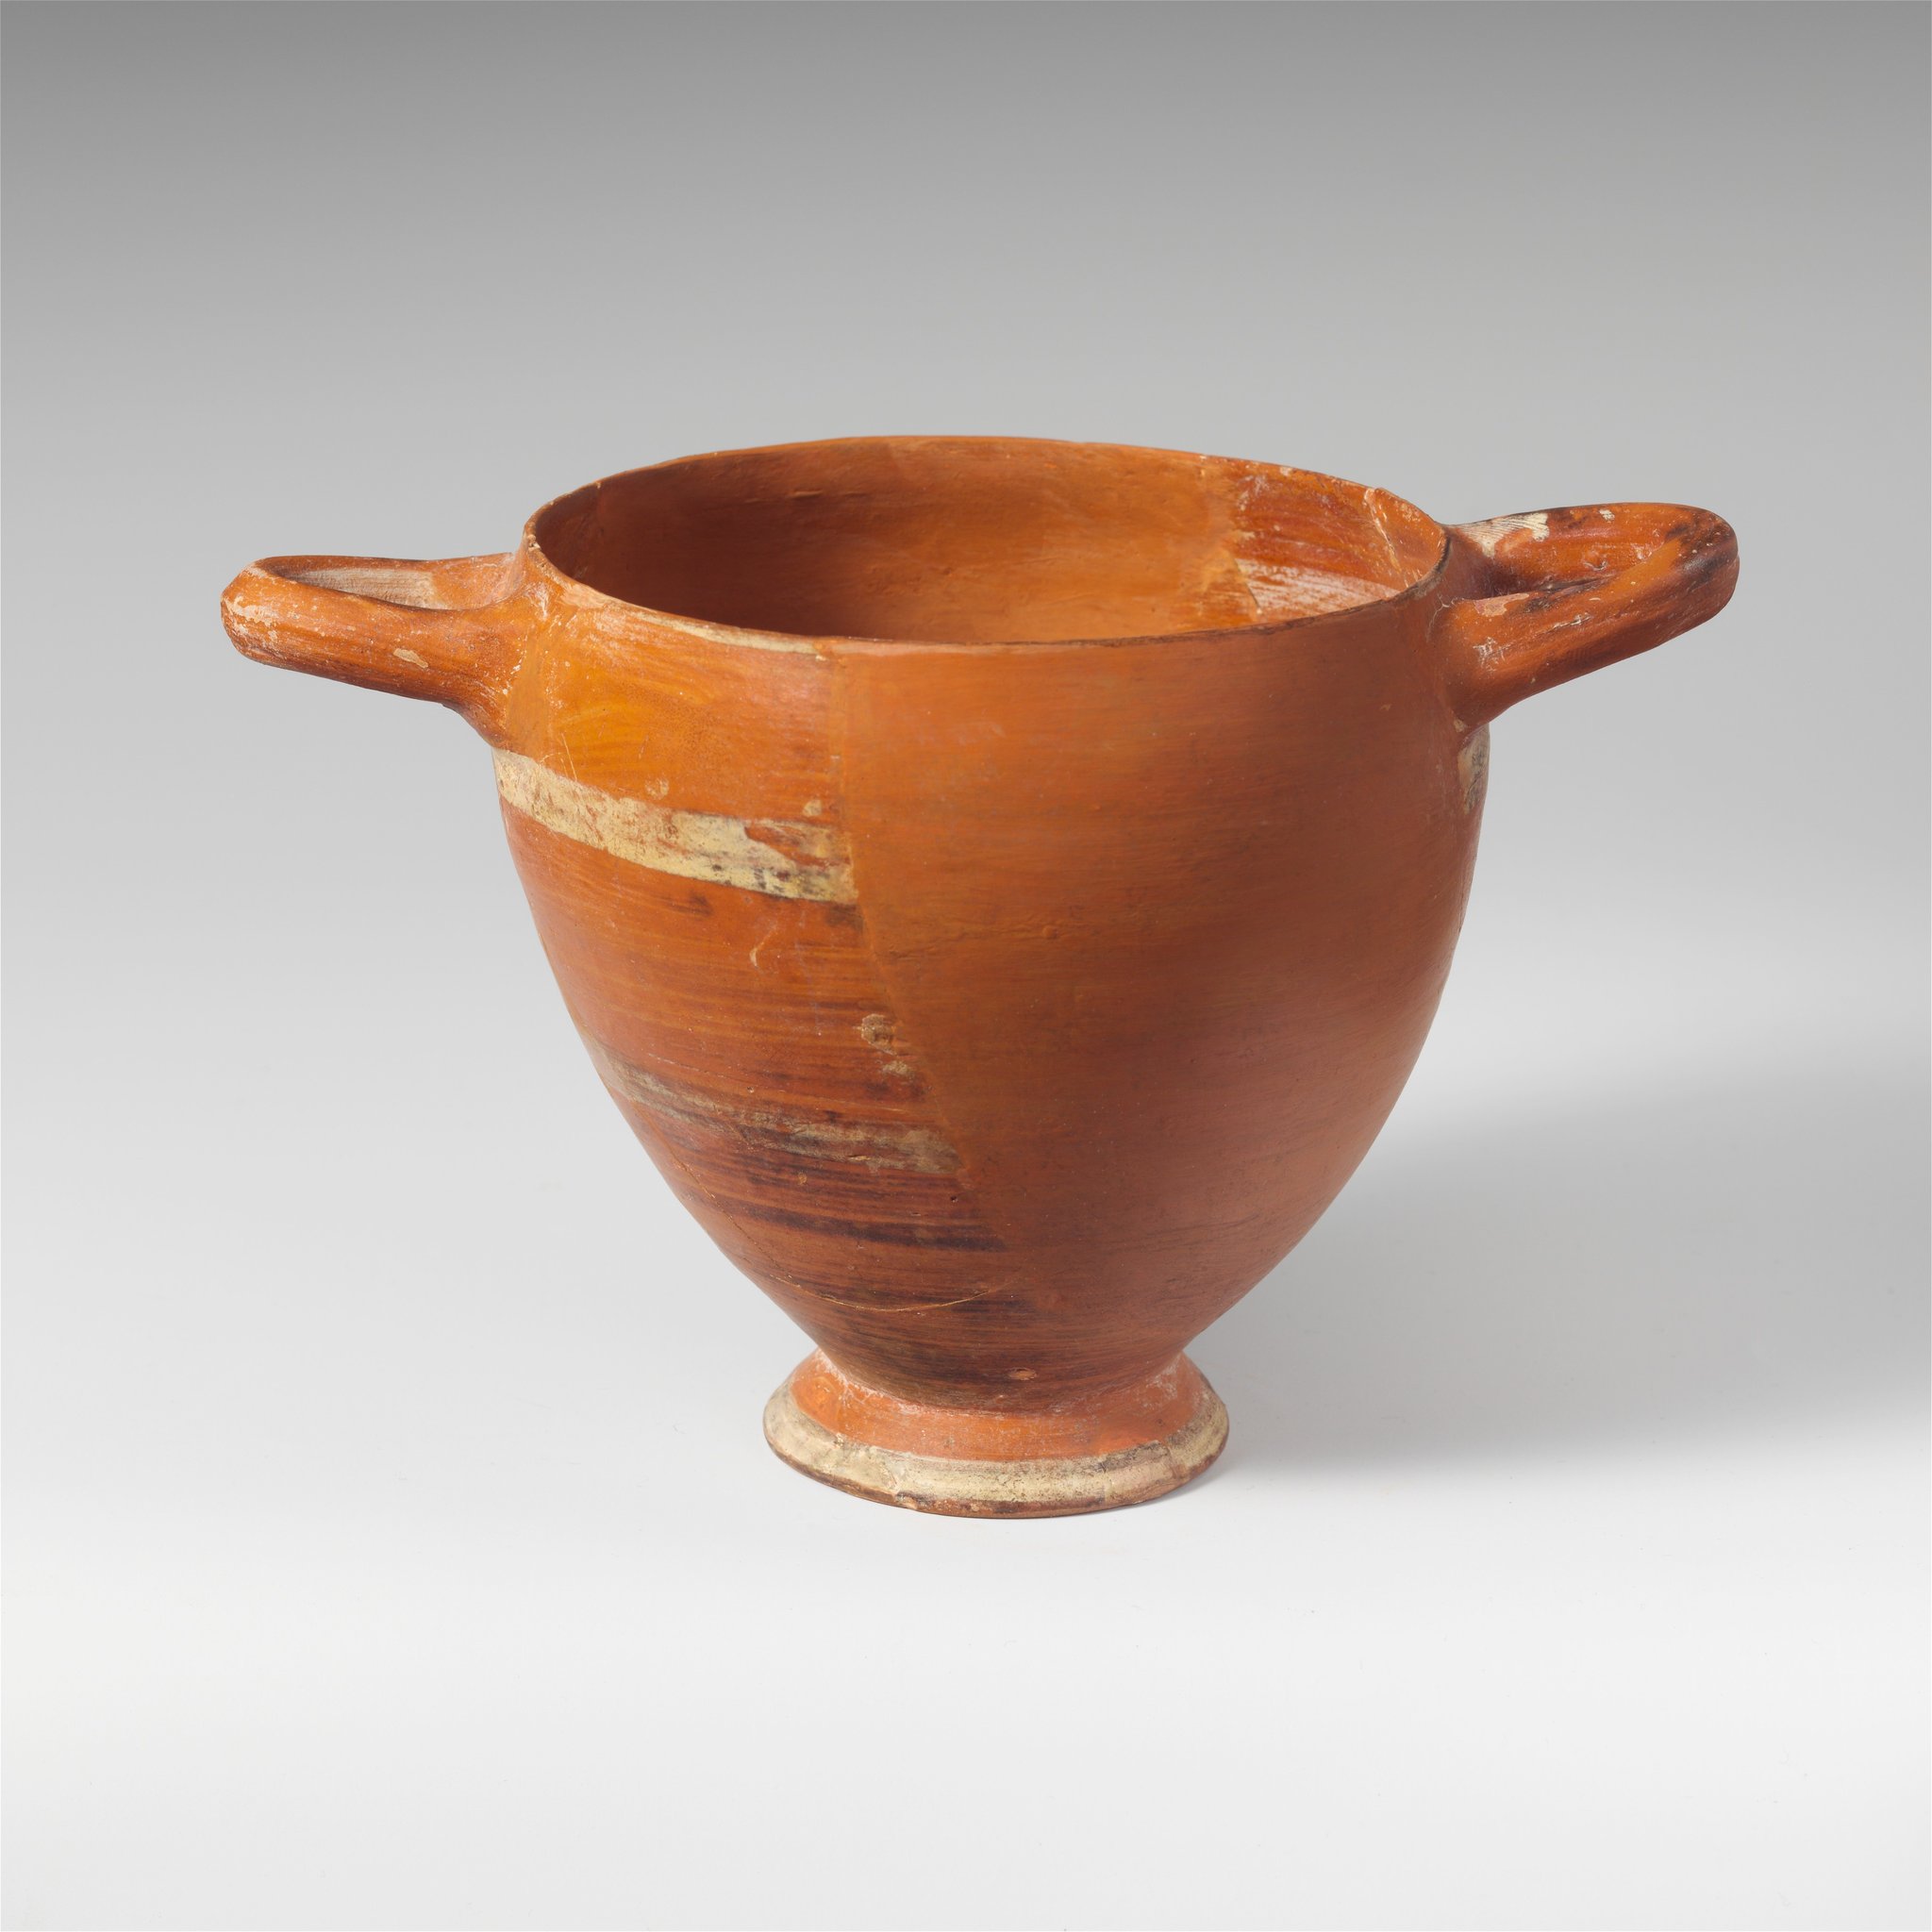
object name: skyphos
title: Terracotta skyphos (deep drinking cup)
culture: lydian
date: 600-501 BCE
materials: terracotta